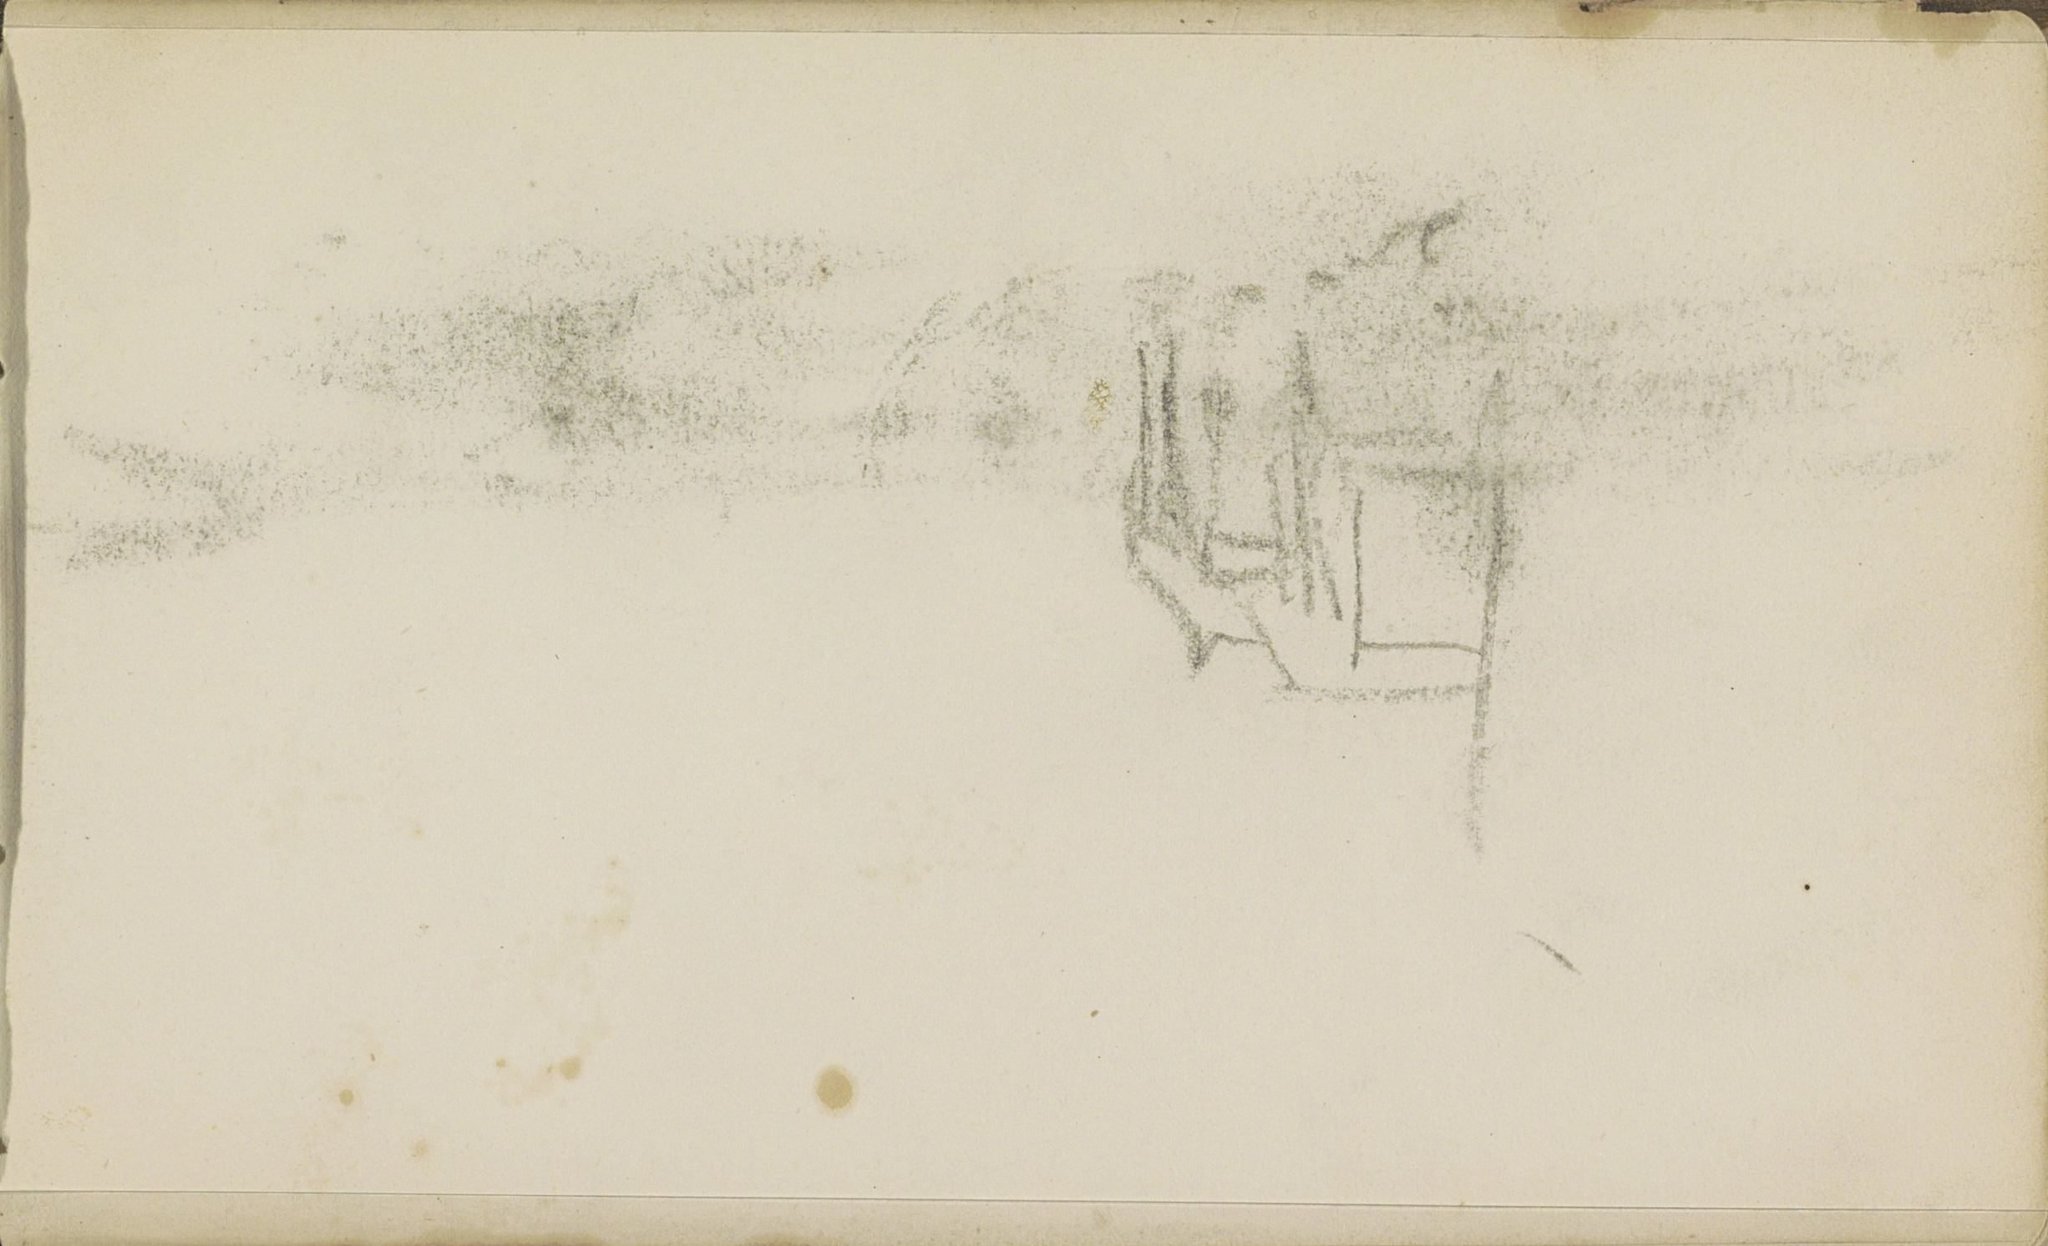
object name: sketchbook leaf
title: Studie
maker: jozef israëls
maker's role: draughtsman, painter, print maker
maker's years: 1824-1911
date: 1834-1911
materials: chalk, paper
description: Blad 12 recto uit een schetsboek met 42 bladen.